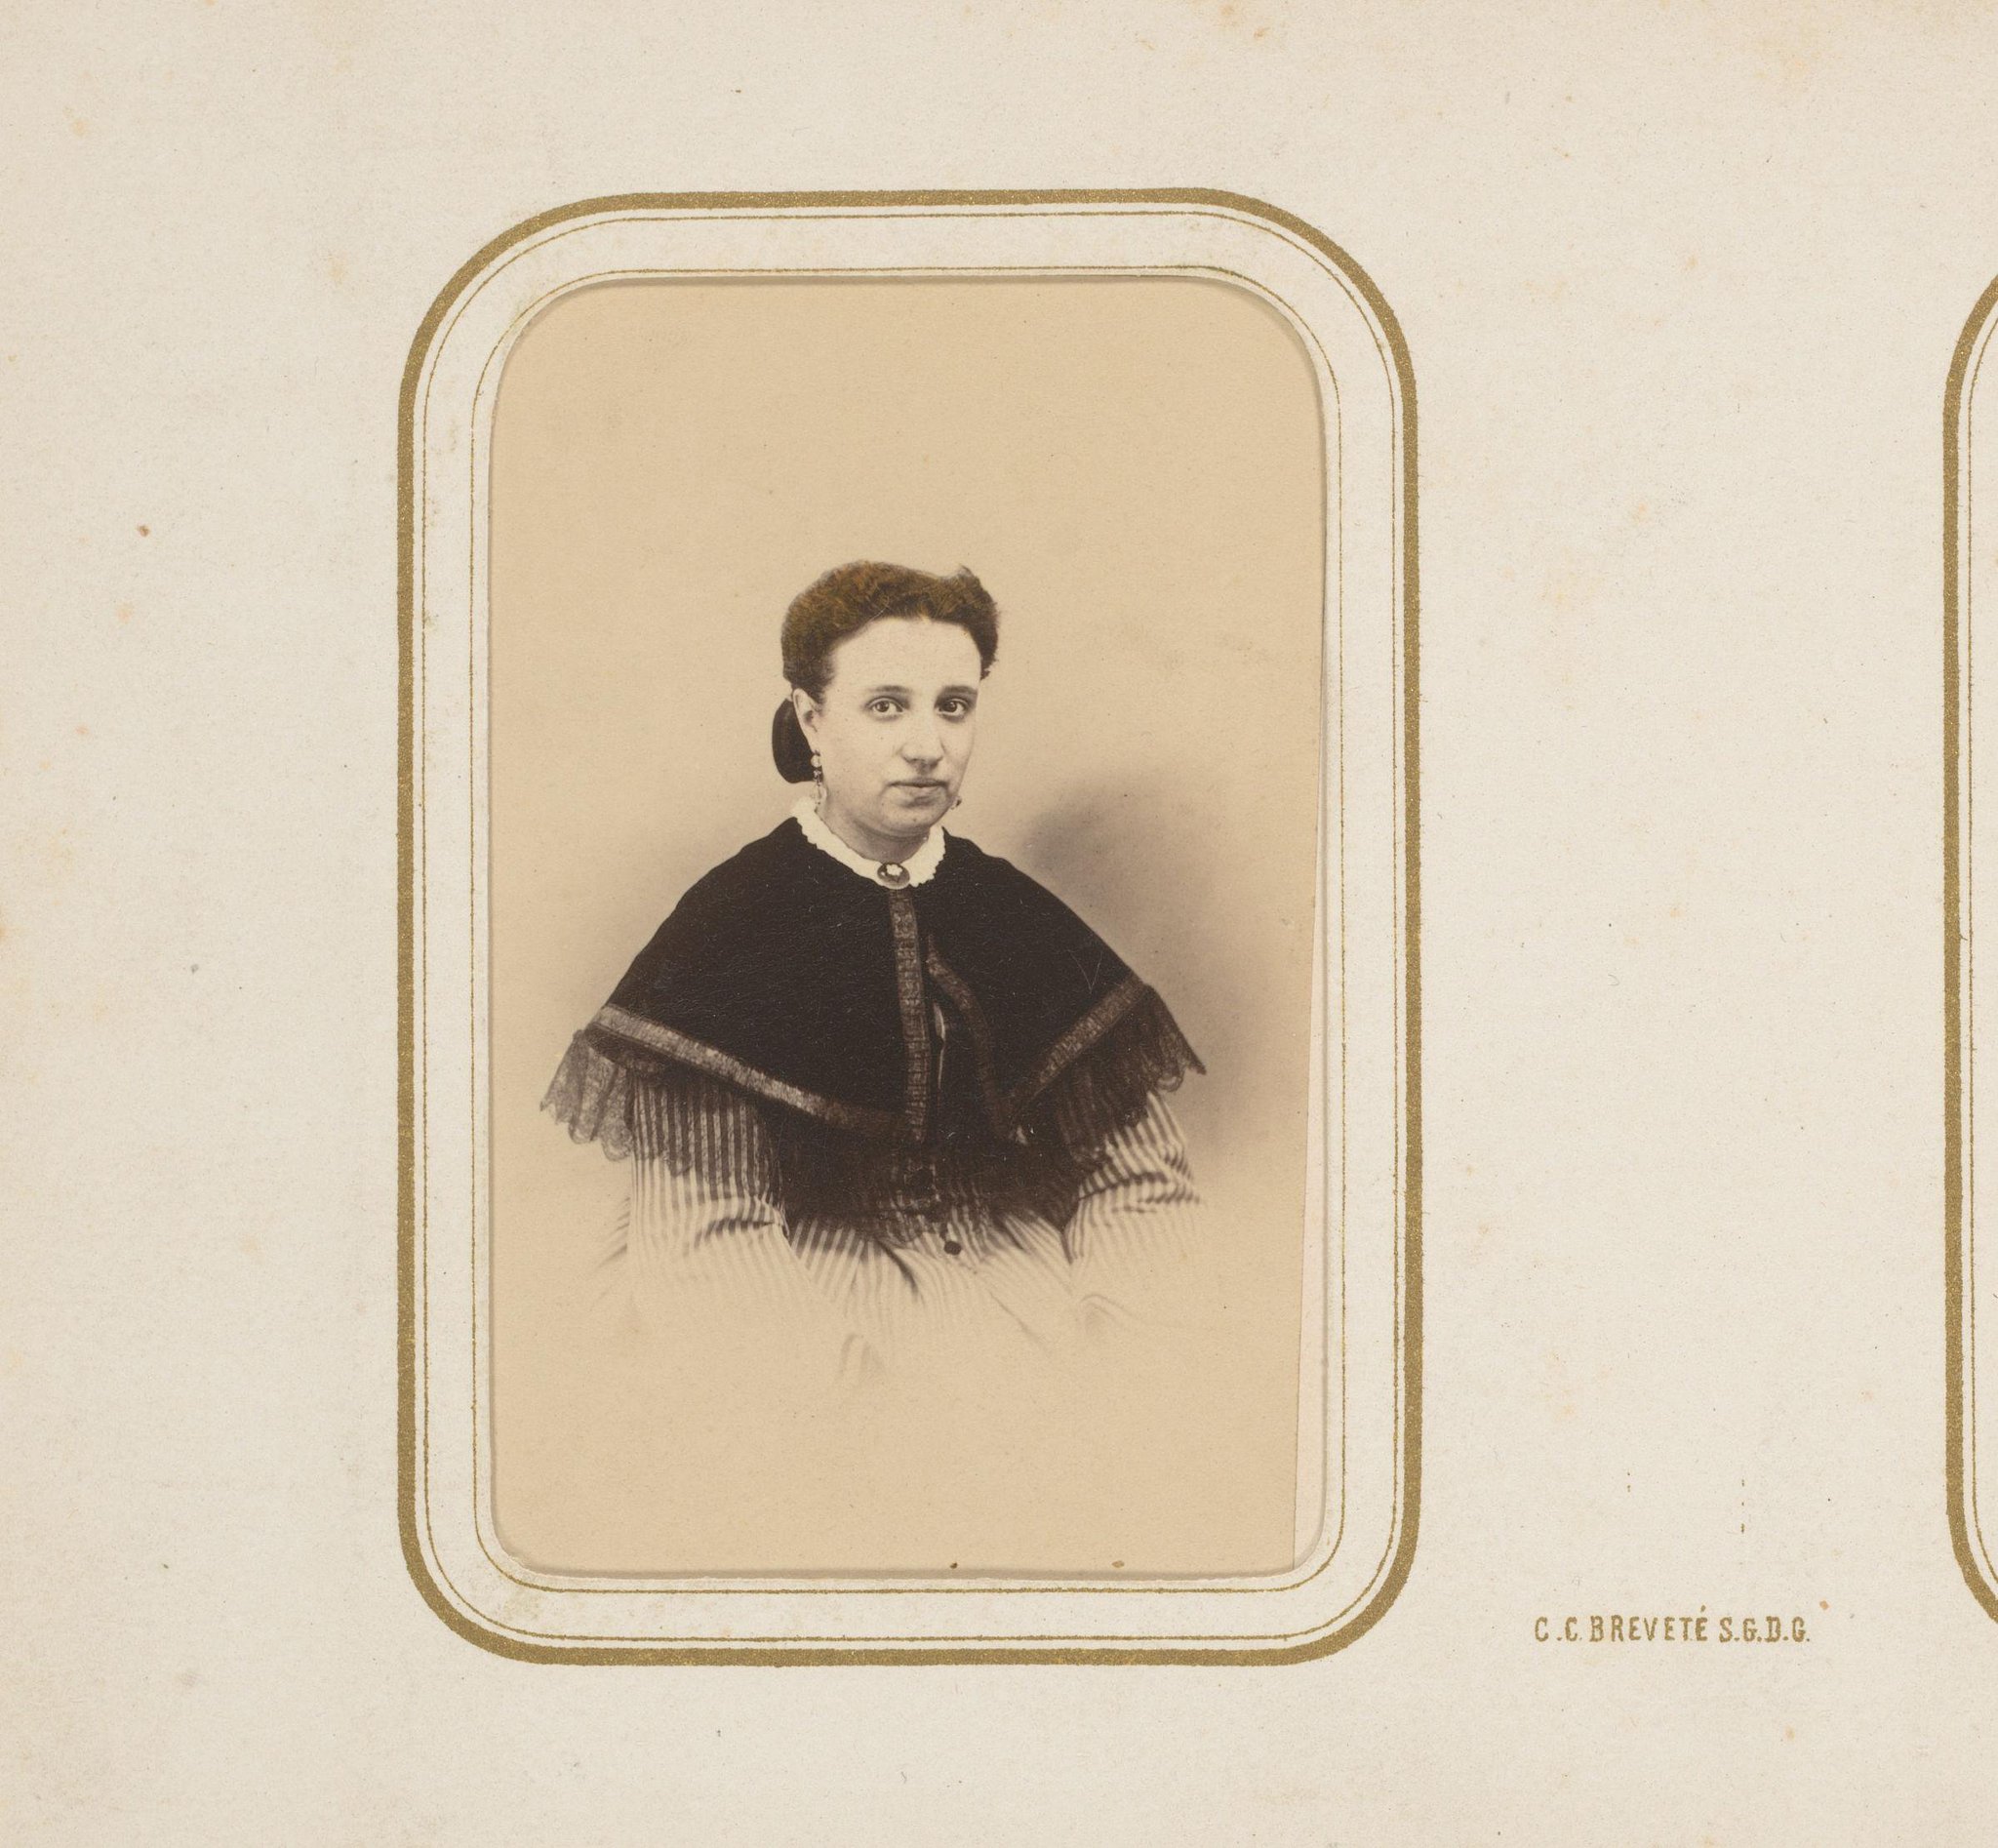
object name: album leaf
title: Portret van een vrouw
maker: antonio sanchez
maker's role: fotograaf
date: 1860-1900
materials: cardboard, photographic support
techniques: albumen print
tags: adult woman, historical persons, ear-rings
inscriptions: inscription: ‘Litografia/ y Fotografia/ de/ A. Sanchez/ (...)/ Carrea de Genil No. 41/ Granada’